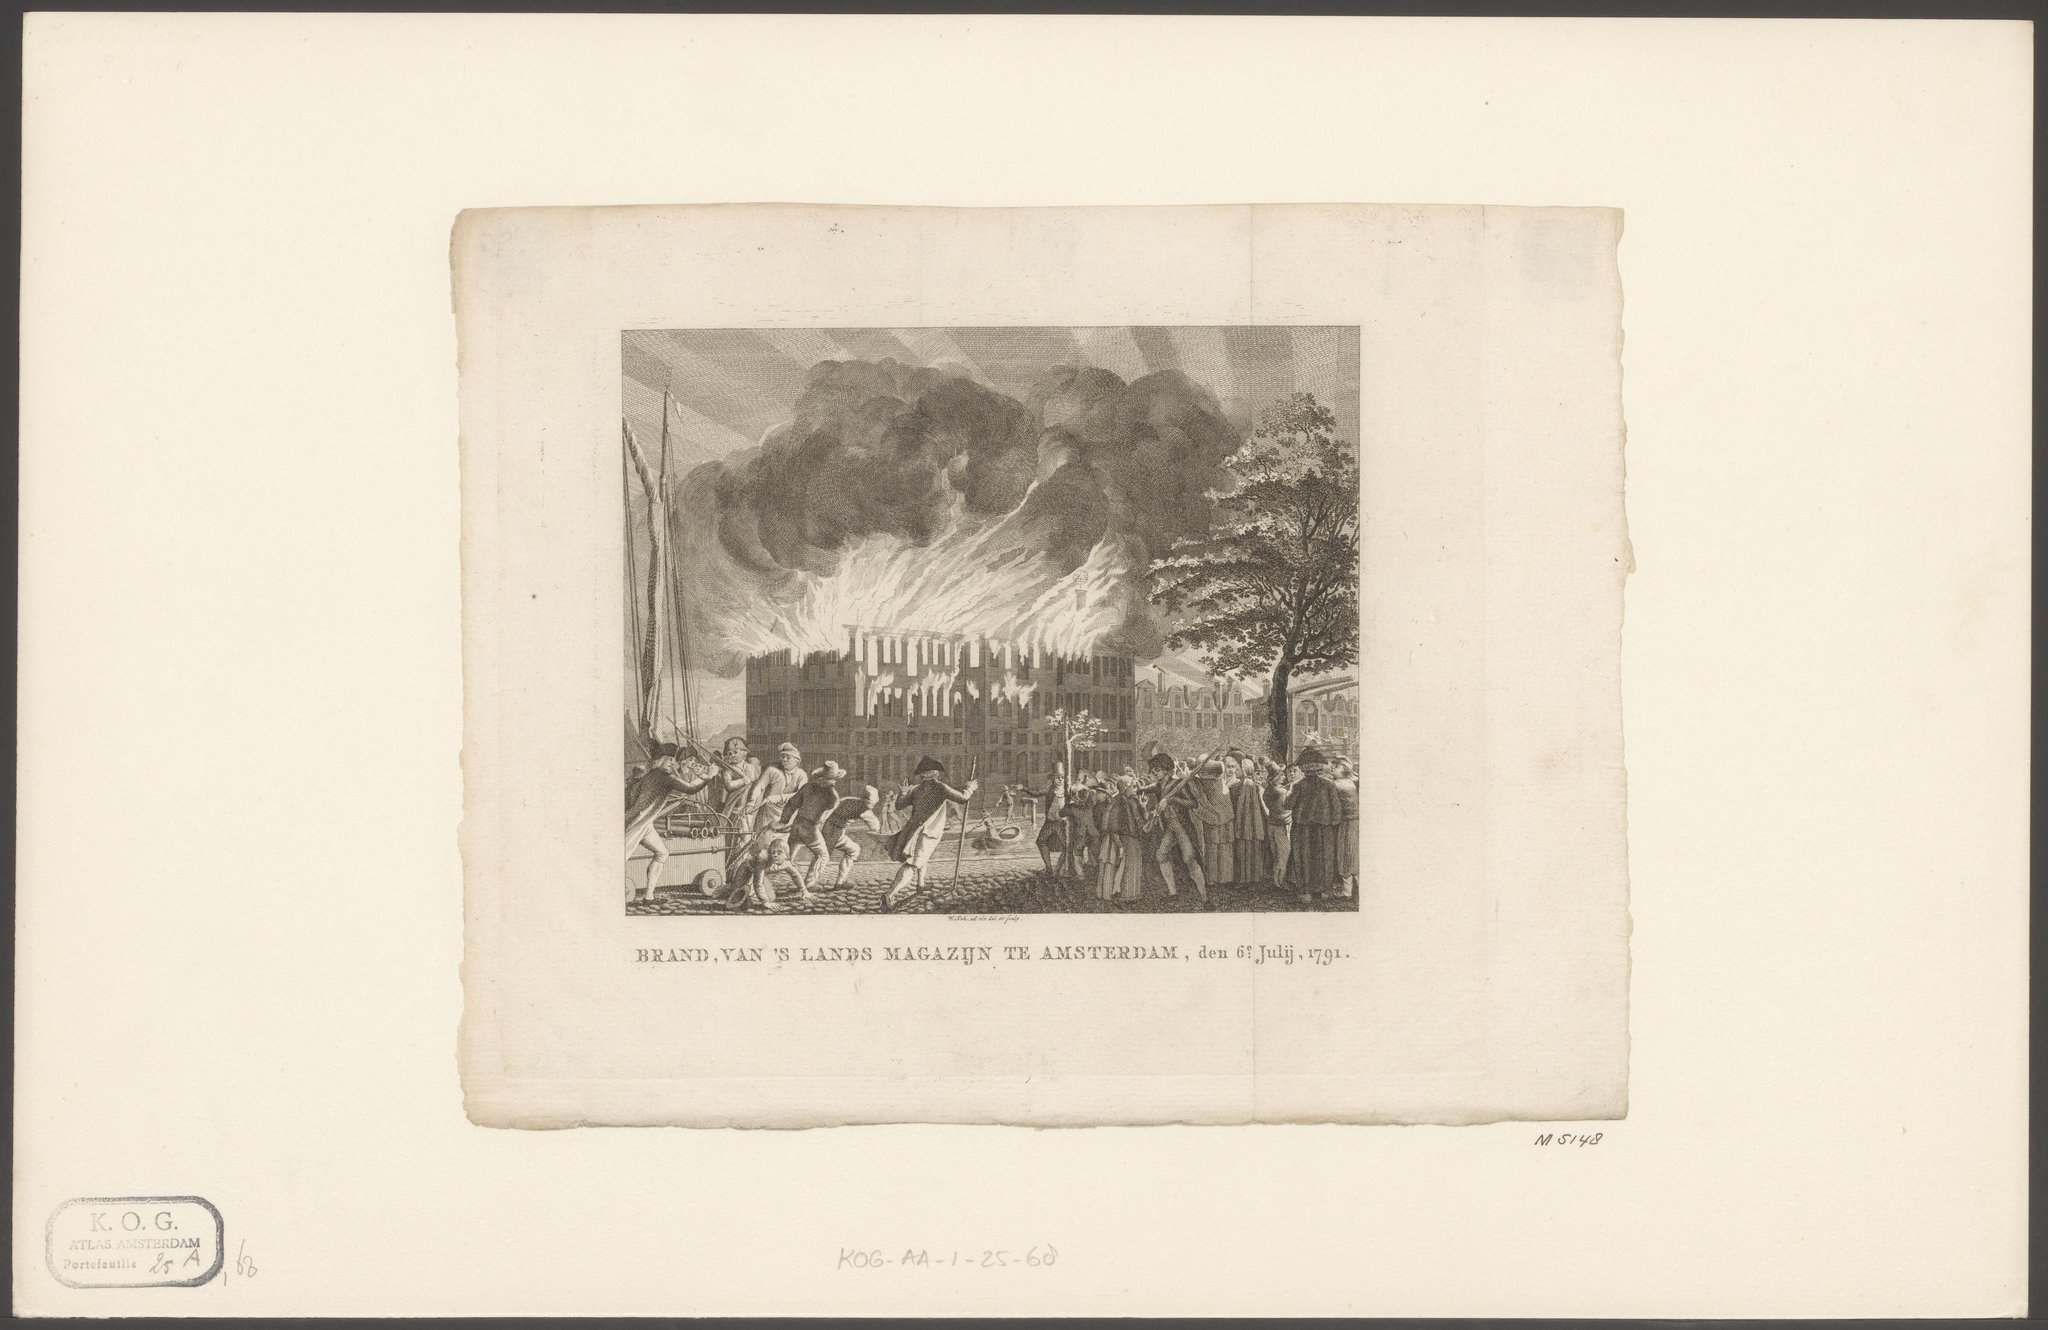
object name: print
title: Brand in 's Lands Zeemagazijn, 1791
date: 1791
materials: paper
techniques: engraving, etching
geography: amsterdam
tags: large-scale structure for storage, e.g.: warehouse, depot, silo, on fire, ablaze, ammunition store, arsenal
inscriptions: collector's mark: ‘25A.68’ Lugt 1641b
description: Onderwerpsrubriek binnen de Atlas Amsterdam: Krijgswezen I: De Admiraliteit van Amsterdam, A. Admiraliteitsgebouwen.